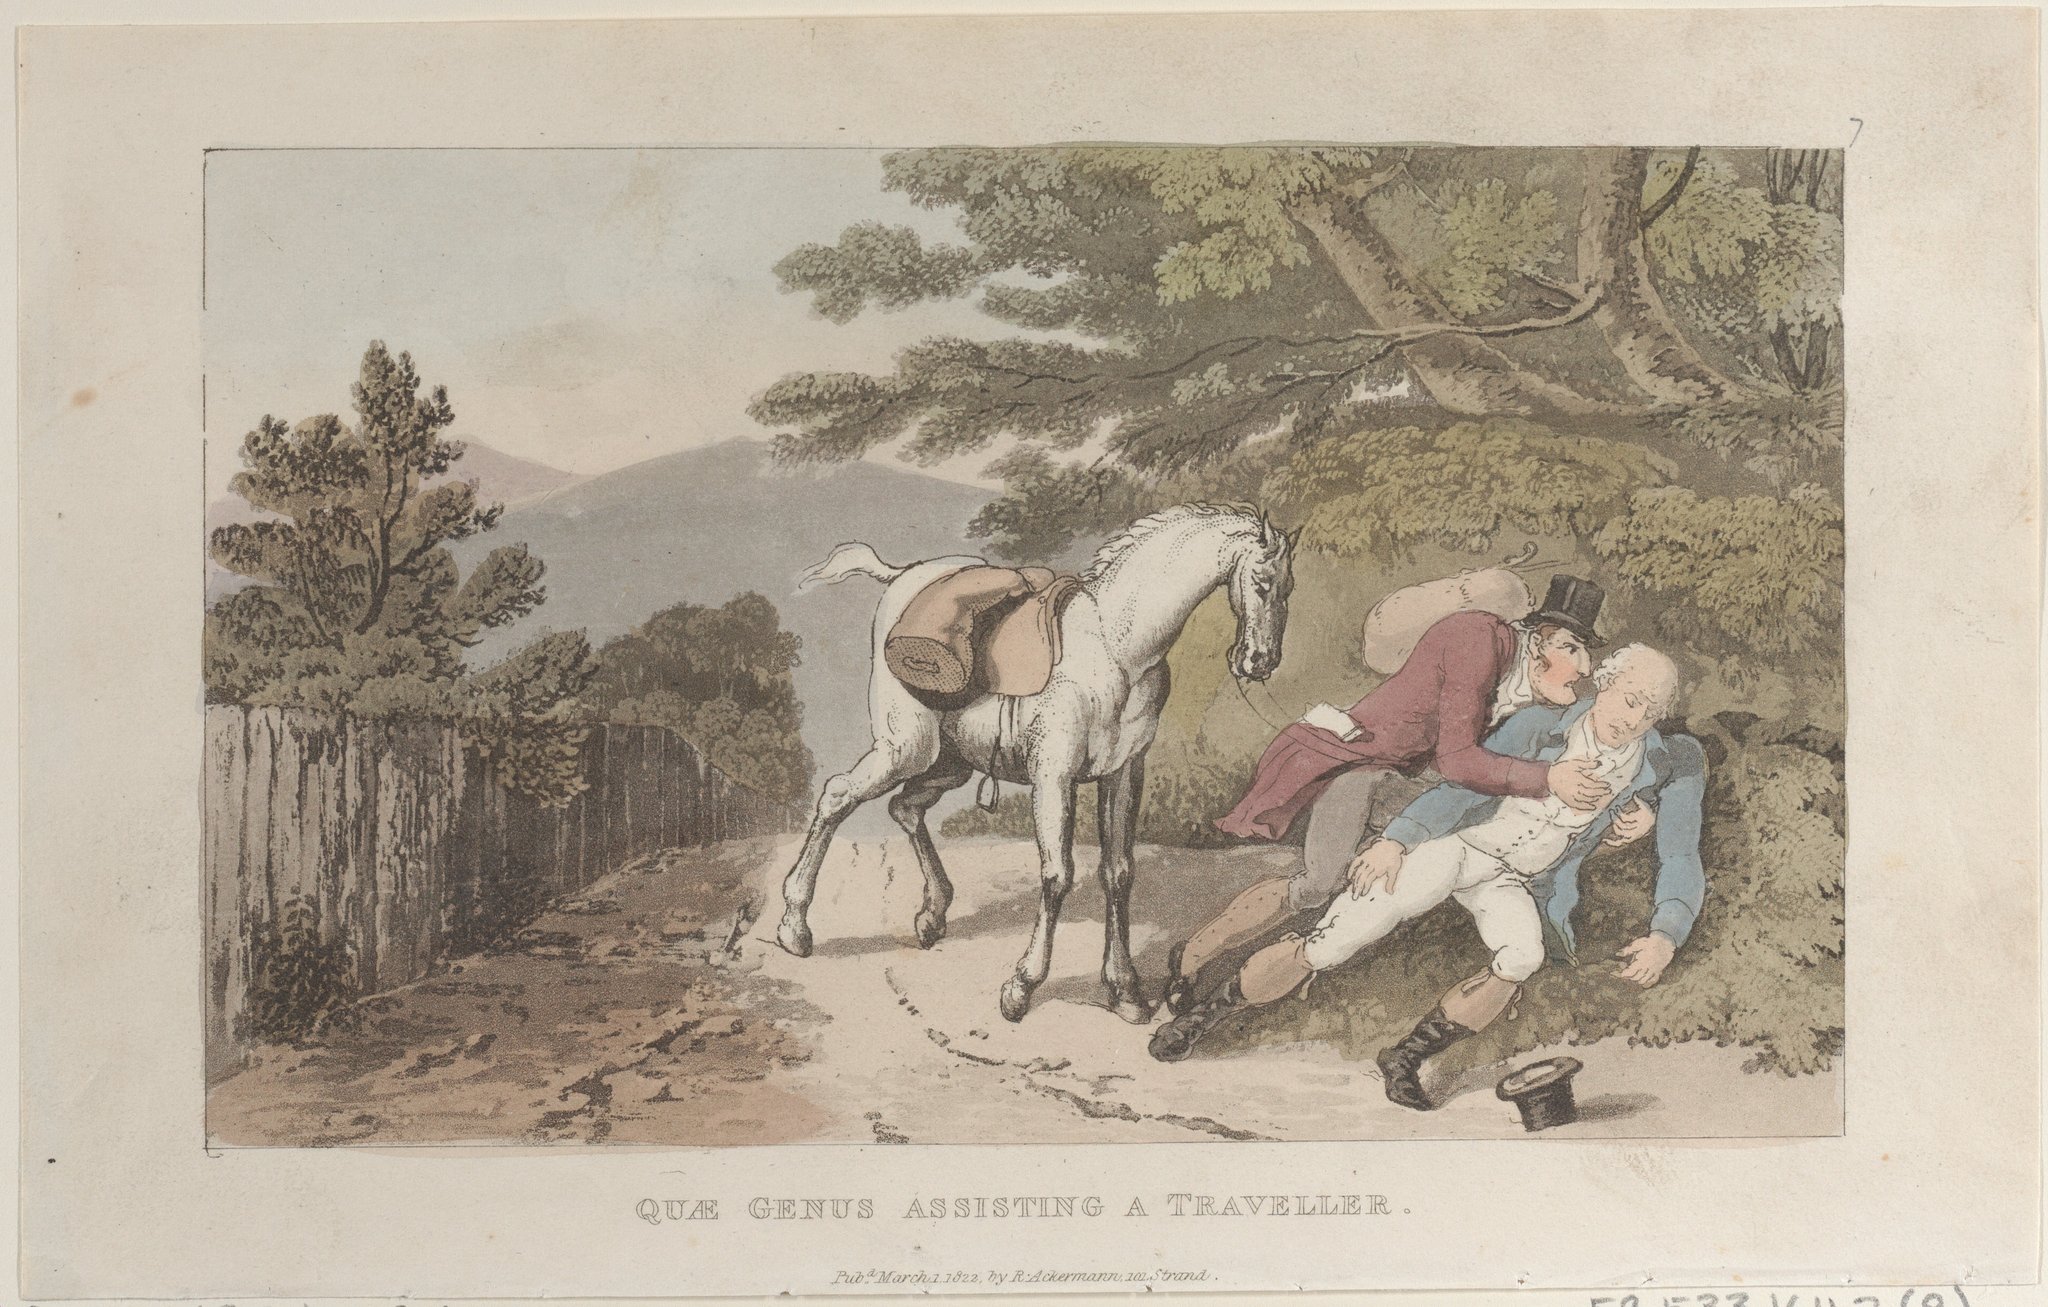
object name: print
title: Quae Genus Assisting a Traveler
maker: thomas rowlandson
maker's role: artist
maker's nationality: british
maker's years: 1757-1827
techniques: aquatint, etching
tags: men,horses